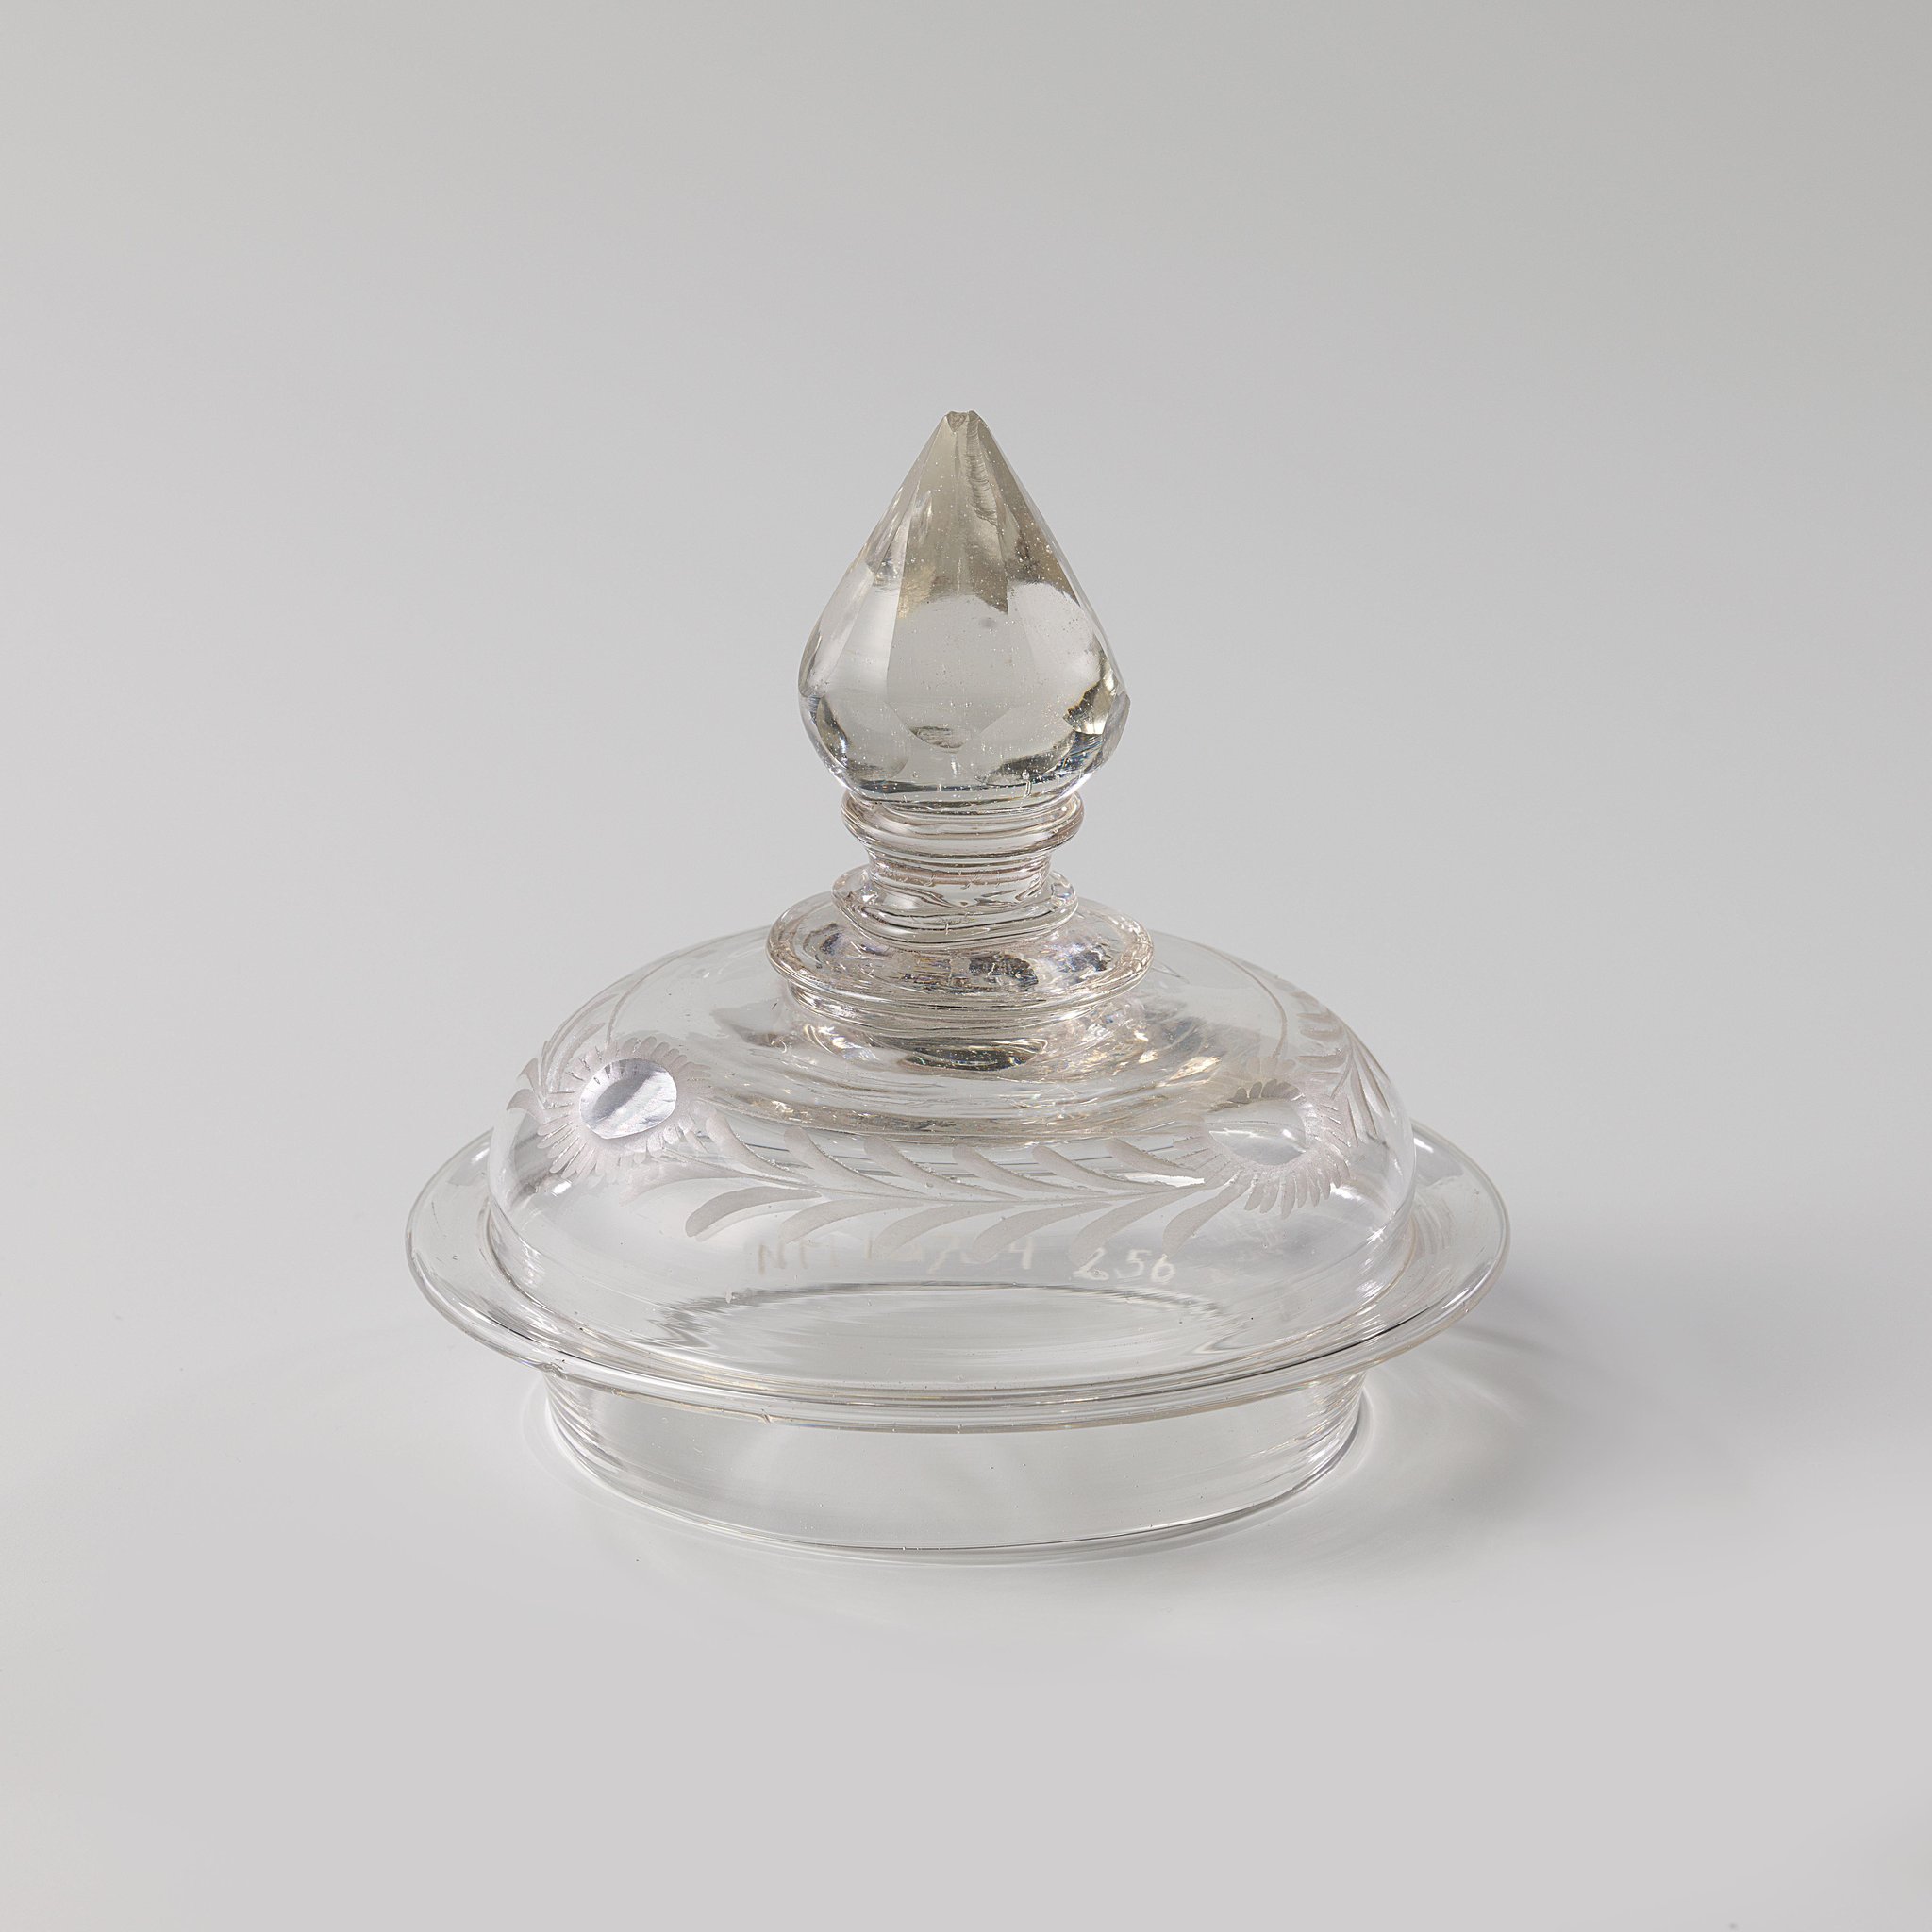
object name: lid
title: Deksel van een bokaal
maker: Anonymous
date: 1750-1800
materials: glass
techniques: glassblowing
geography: bohemia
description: Gewelfde deksel met gefacetteerde, peervormige knop op drie schijven. Op de deksel rondlopend een gegraveerde bloem- en bladslinger.